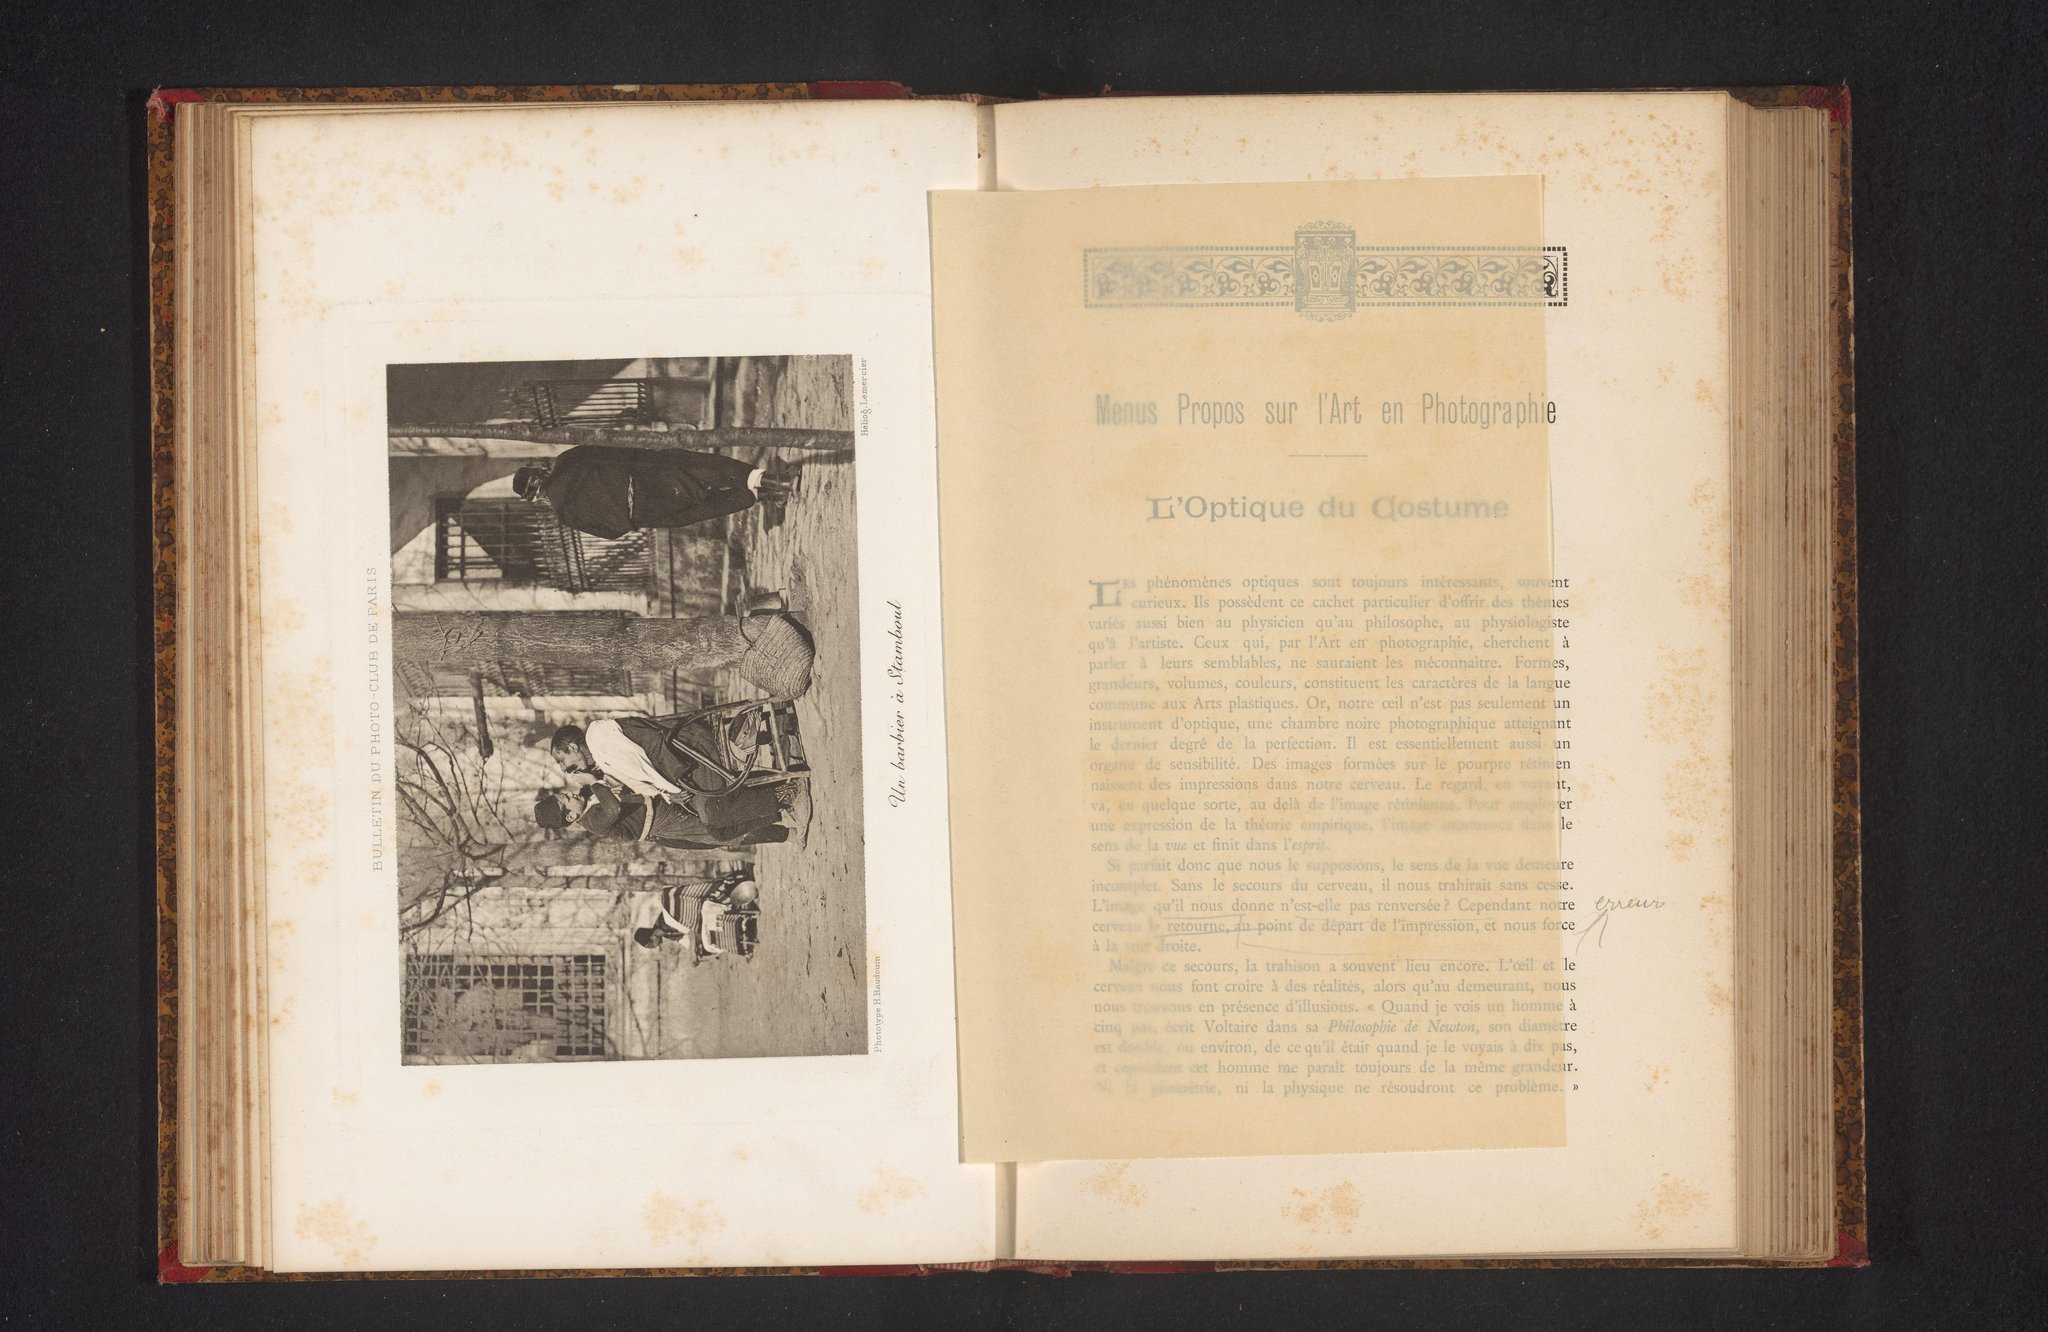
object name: photomechanical print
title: Een kapper in Istanbul knipt iemand op straat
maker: h. baudouin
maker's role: fotograaf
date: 1888-1893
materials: paper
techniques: photograph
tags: hairdresser, street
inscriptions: inscription: ‘Bulletin du Photo-Club de Paris’